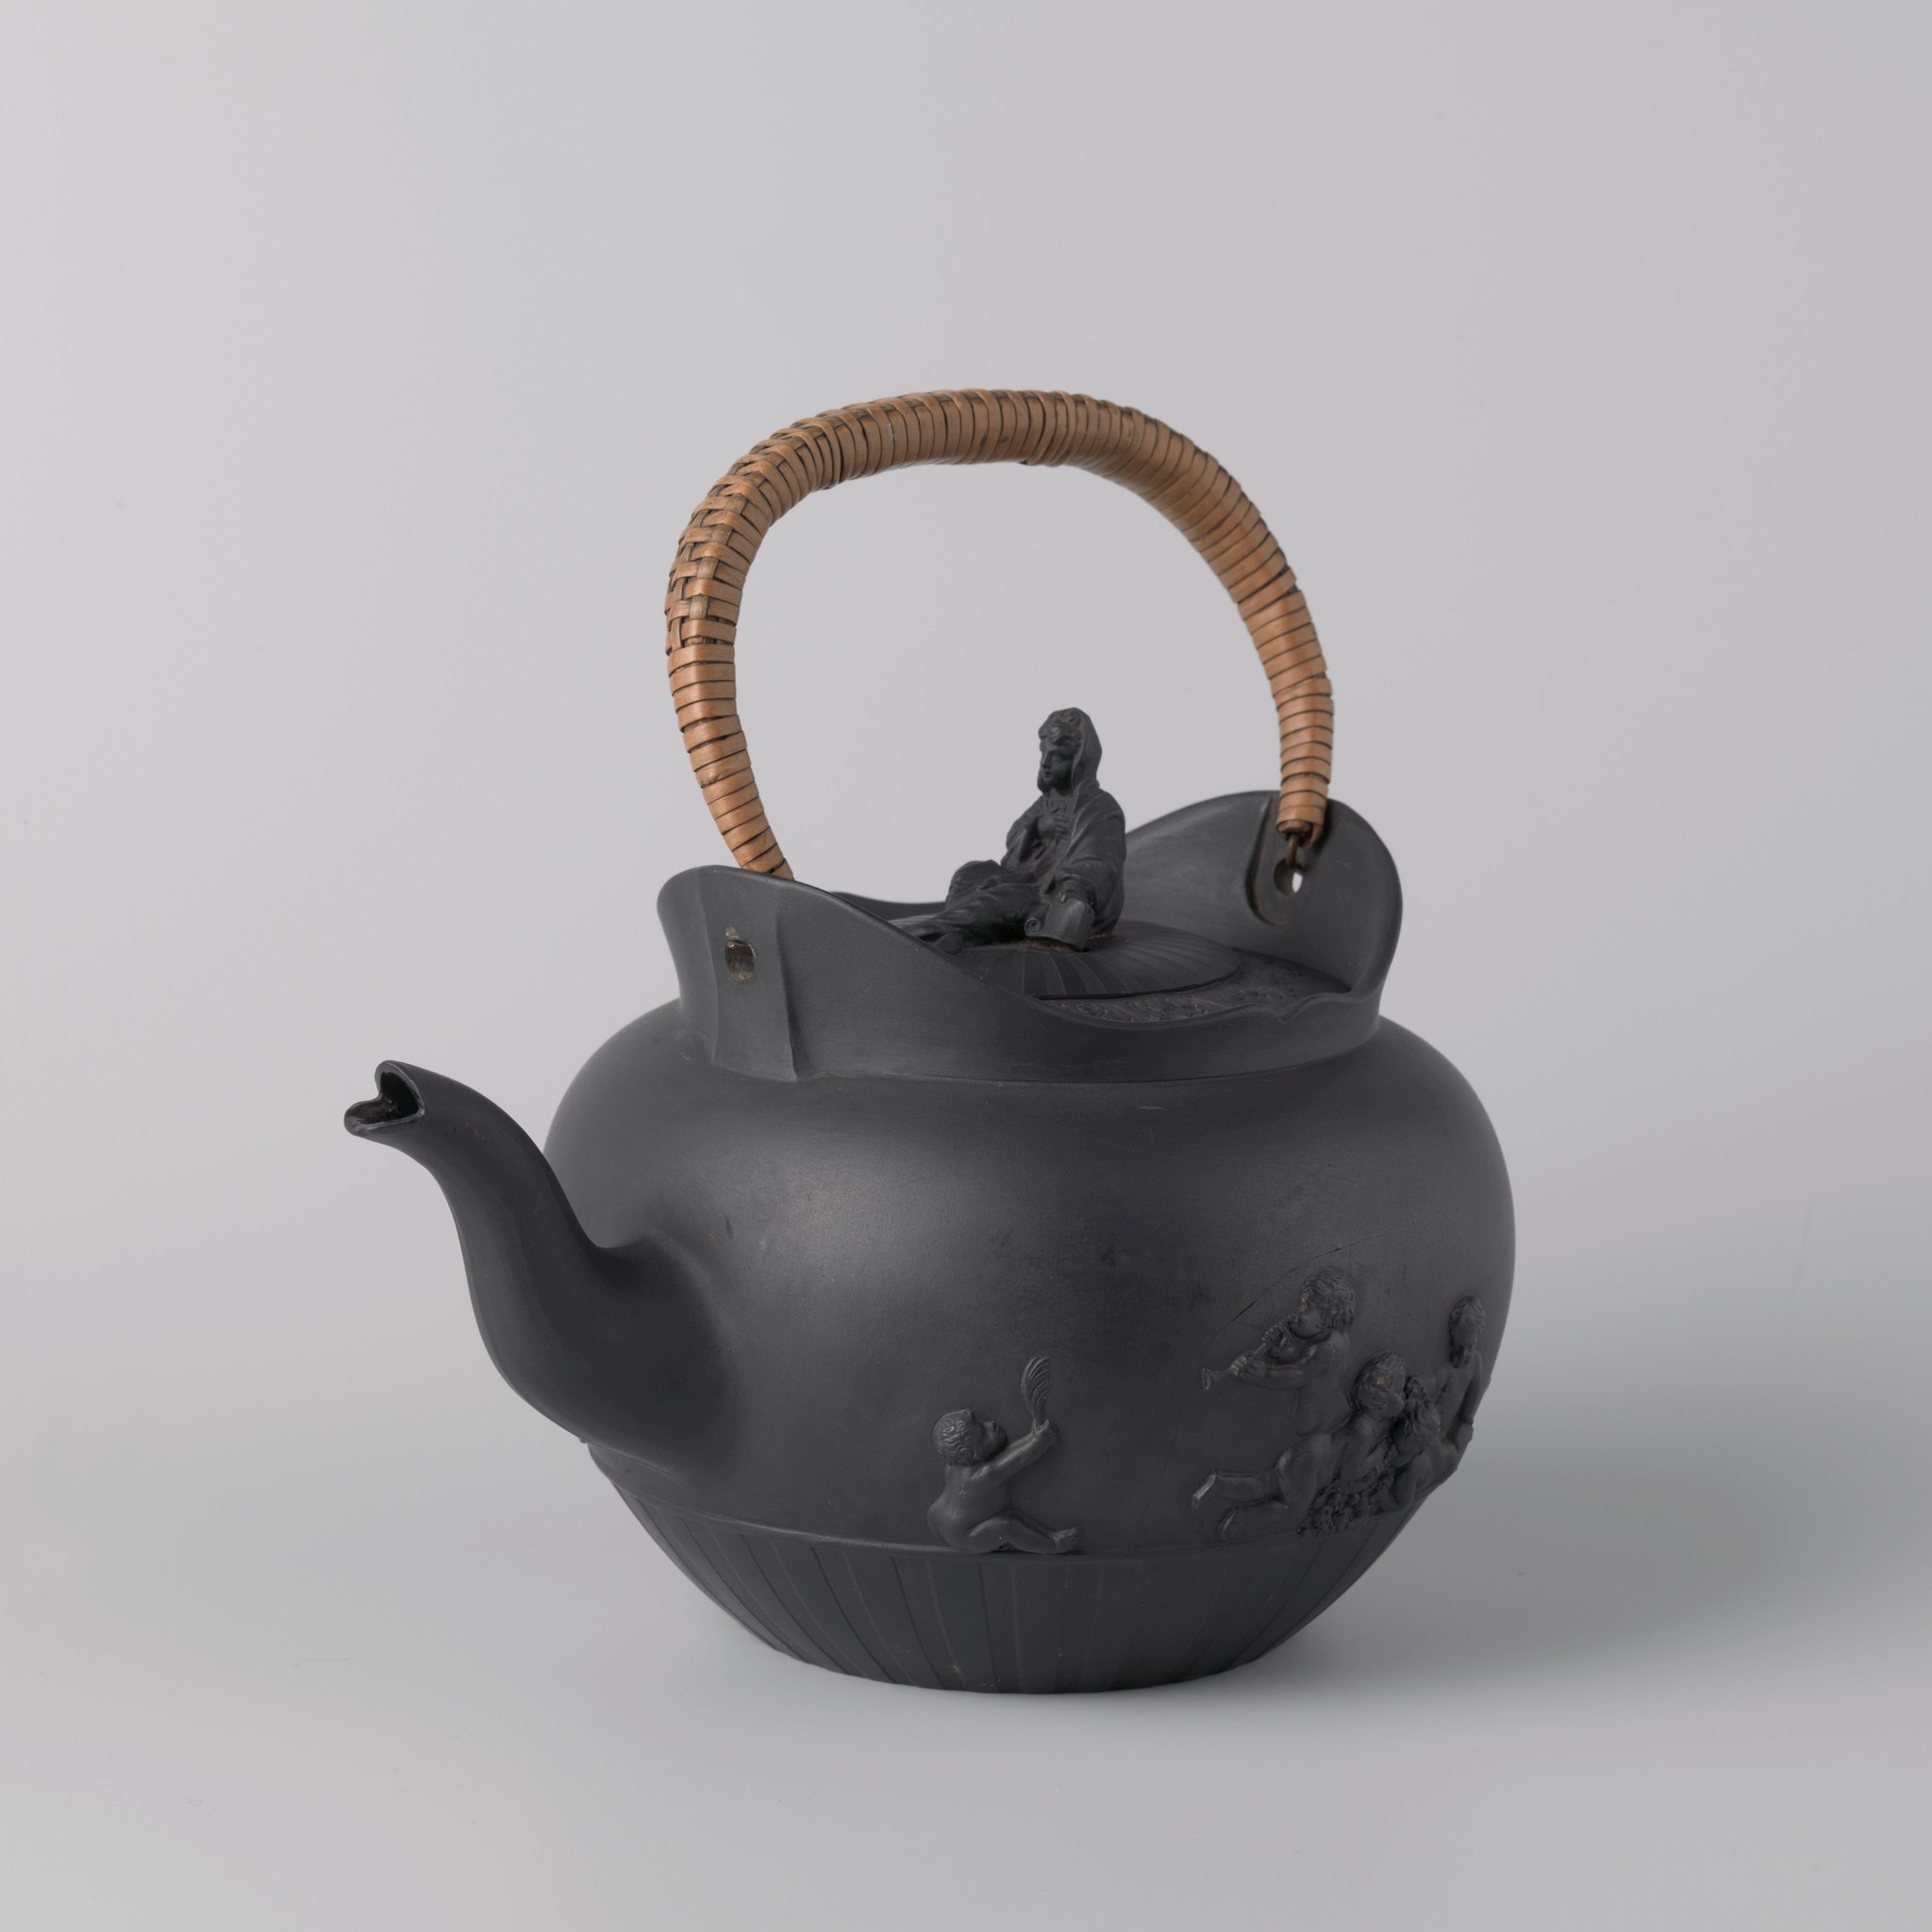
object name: chocoladeketel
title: Chocoladeketel met deksel van aardewerk, Wedgwood Black Basalt. Met deksel.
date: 1785-1800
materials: earthenware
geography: england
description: Bolvormige chocoladeketel met deksel van aardewerk, Black Basalt. De ketel heeft een opstaande, accoladevormige rand met twee gaten waarin het losse hengsel van omwonden riet hangt. De tuit is S-vormig. De buik van de ketel is in reliëf versierd met spelende naakte kinderen, boven een rand van uitgeslepen verticale biezen. De ketel is gemerkt.